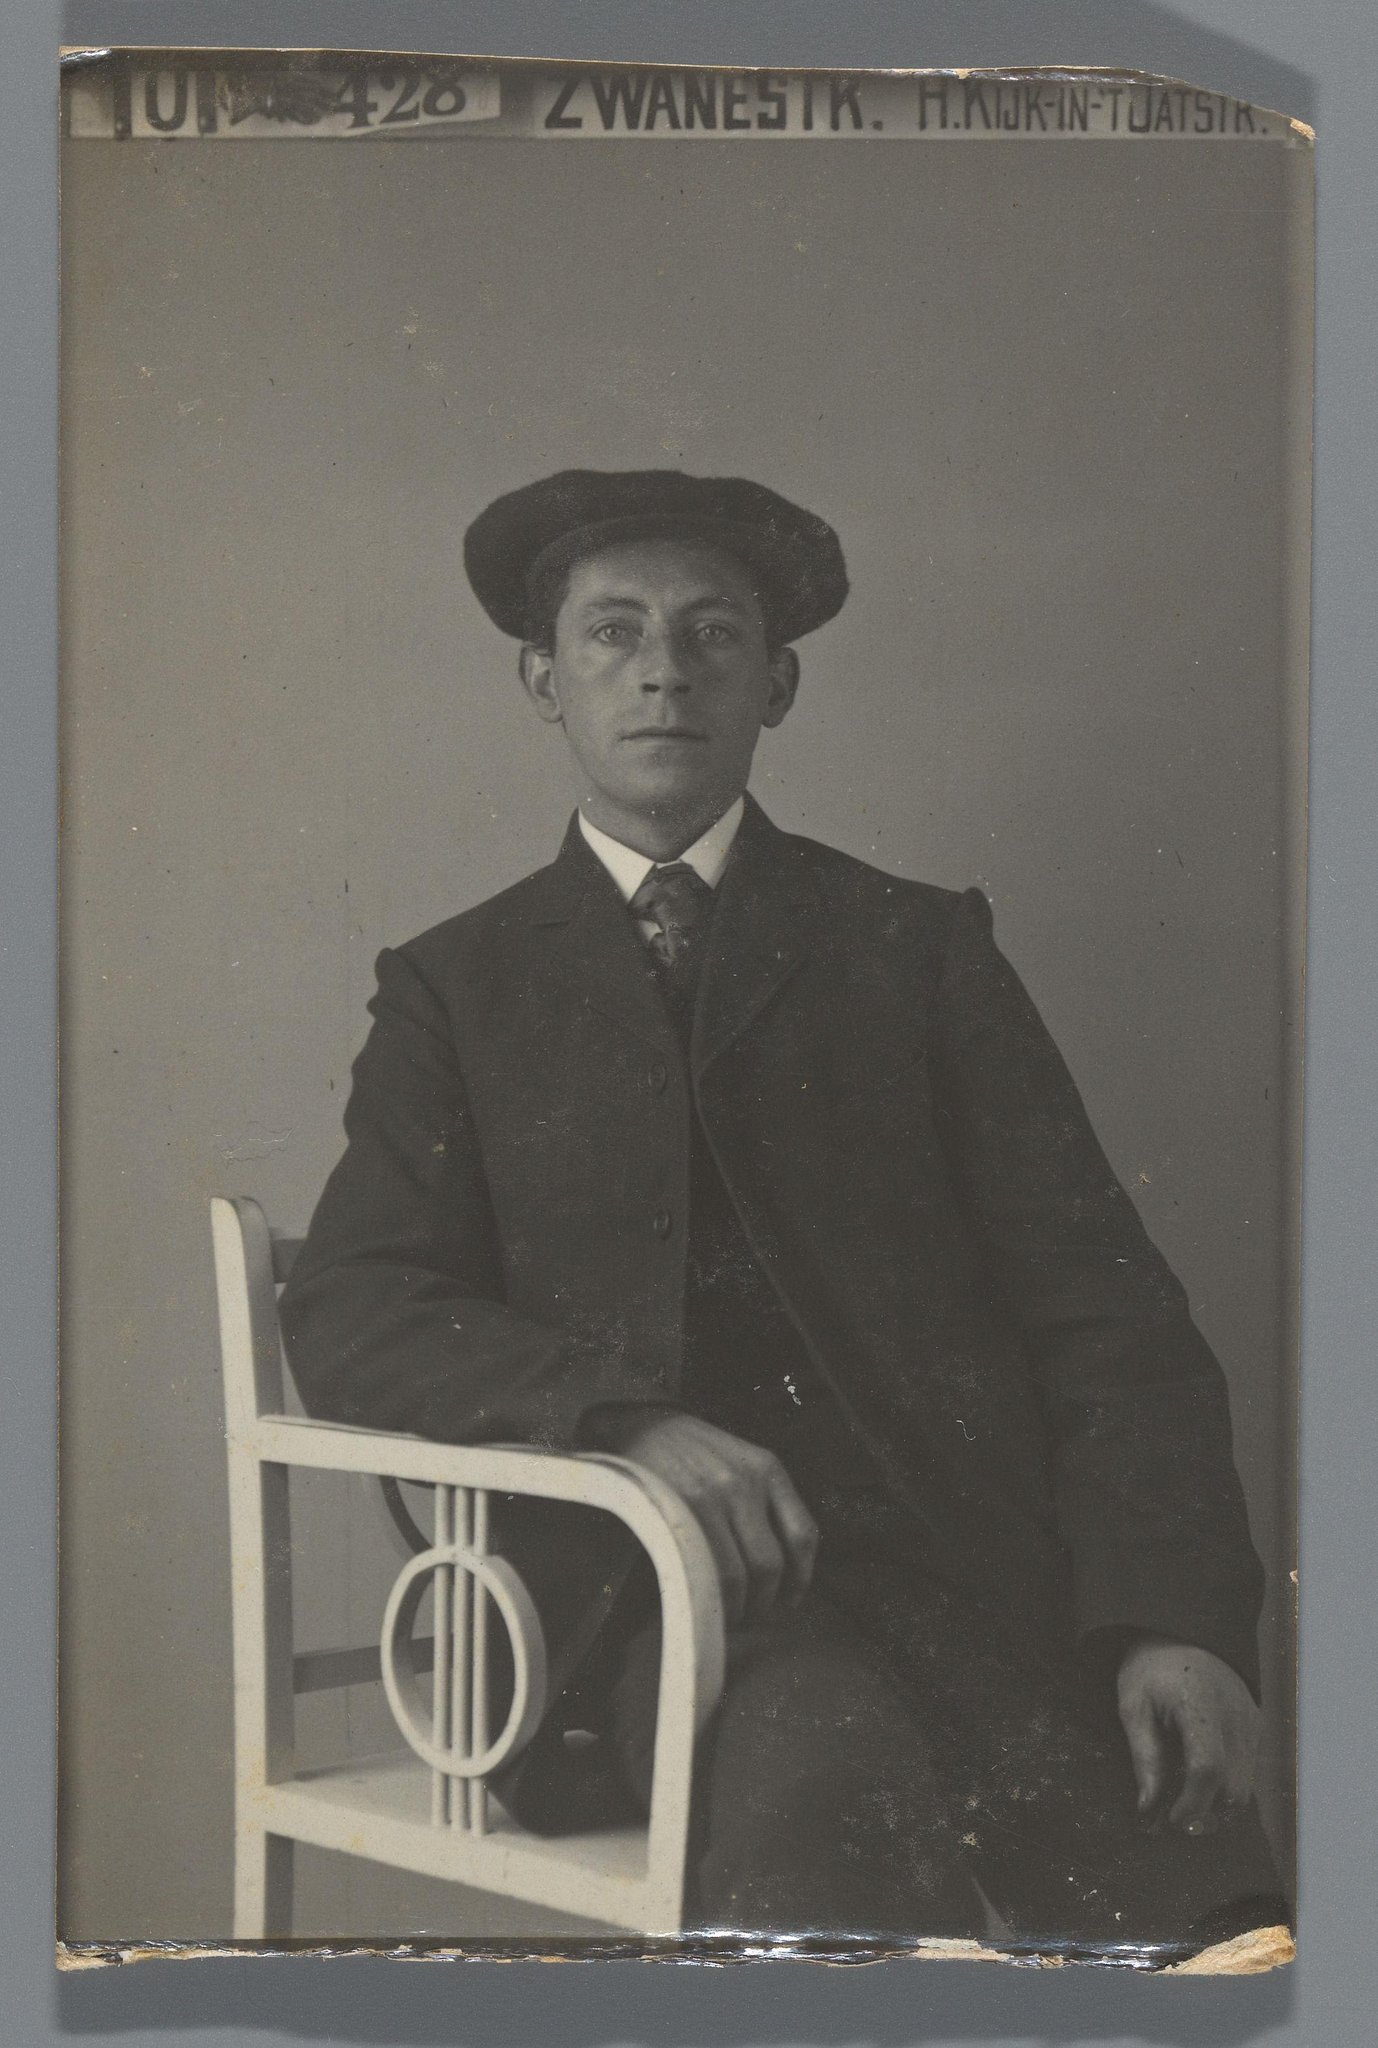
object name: snapshot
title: Portret van een man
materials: photographic support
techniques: gelatin silver print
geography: groningen